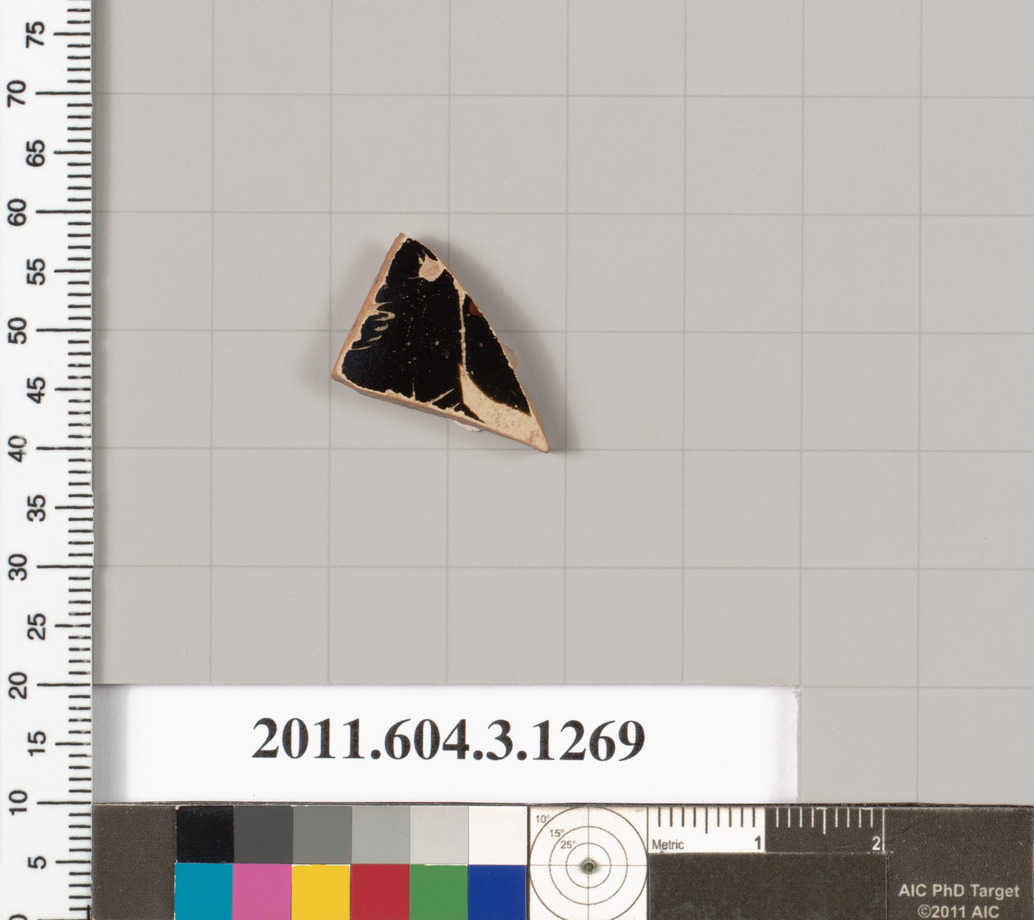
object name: oinochoe fragment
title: Terracotta fragment of an oinochoe (jug)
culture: greek, attic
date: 534-468 BCE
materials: terracotta